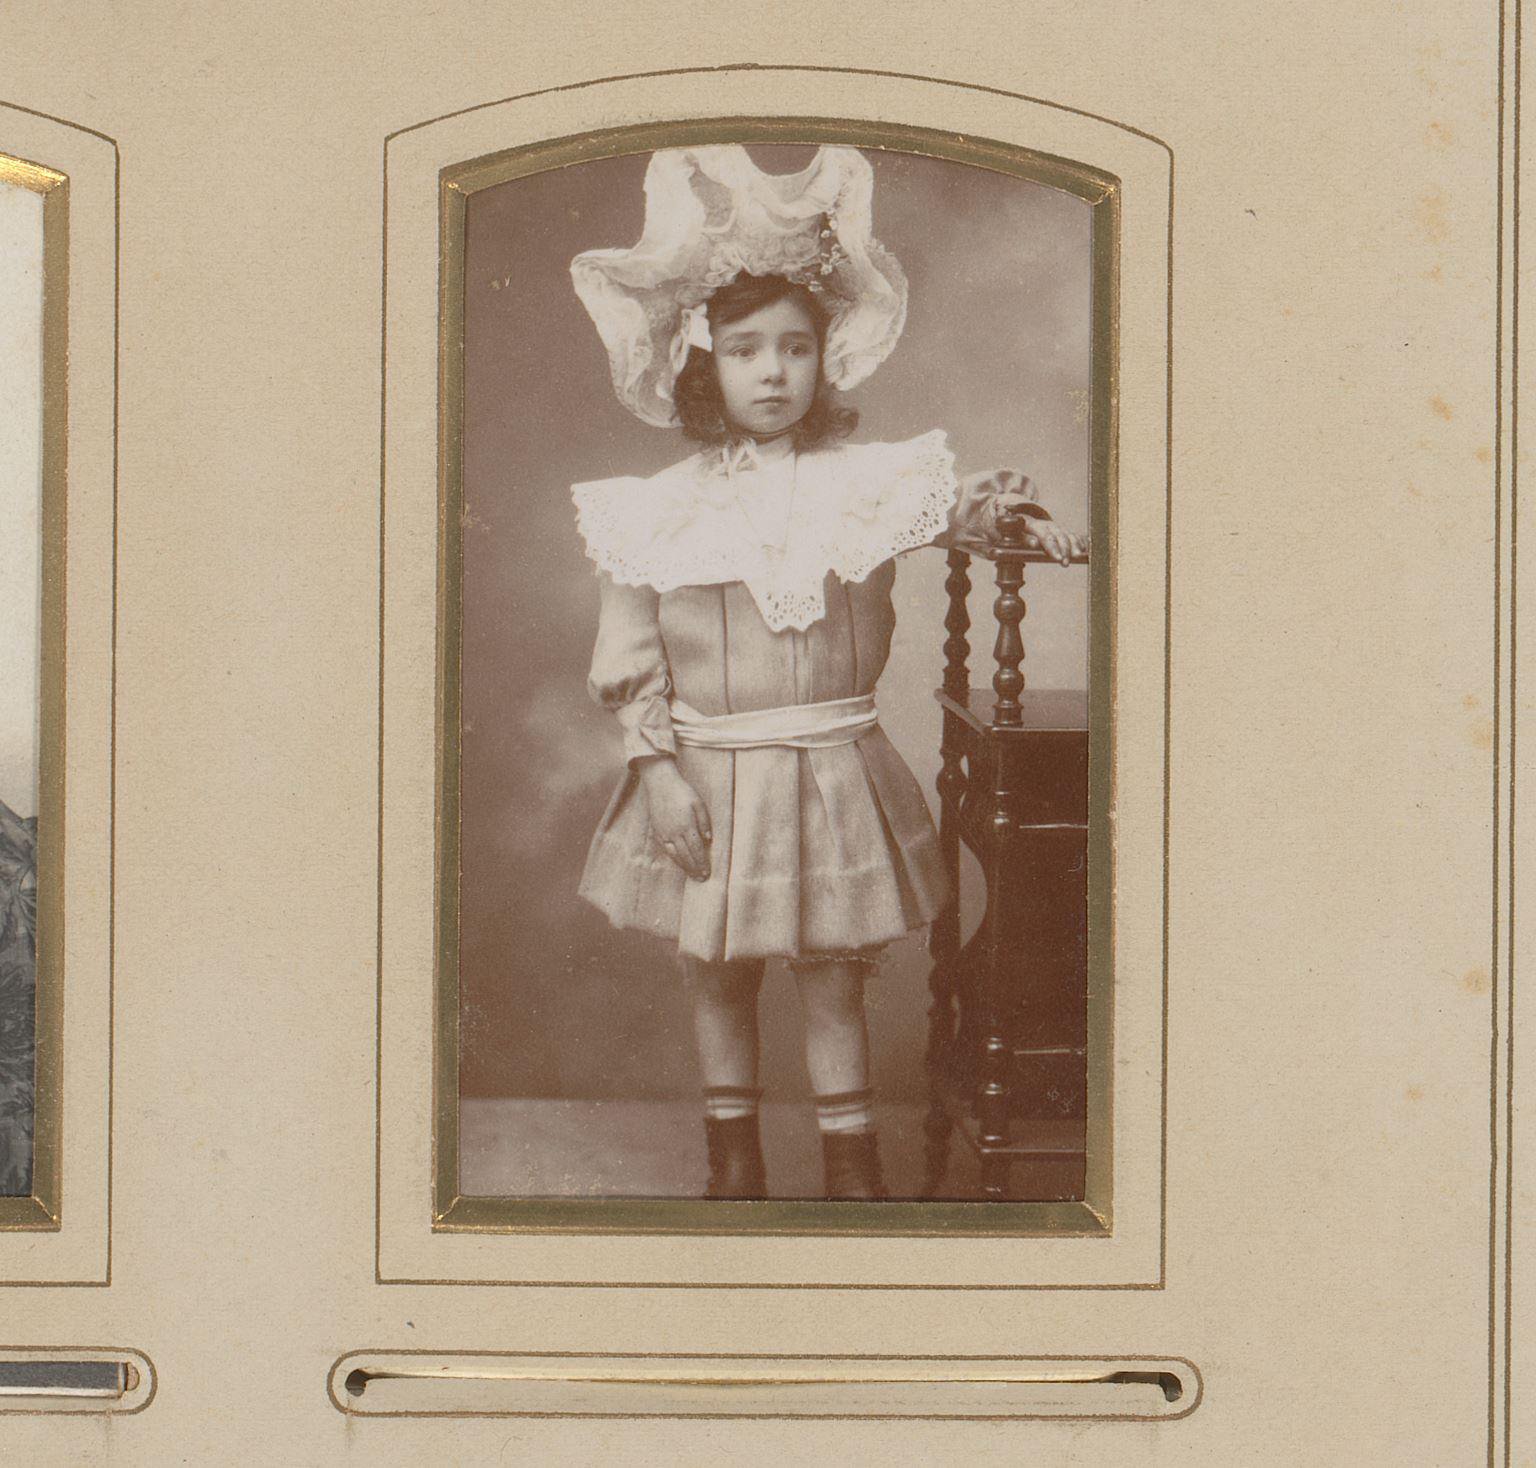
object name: carte de visite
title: Portret van een staand meisje met hoed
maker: Anonymous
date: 1880-1920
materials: cardboard, photographic support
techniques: collodion silver print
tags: historical persons - bb - woman, girl (child between toddler and youth), head-gear: hat